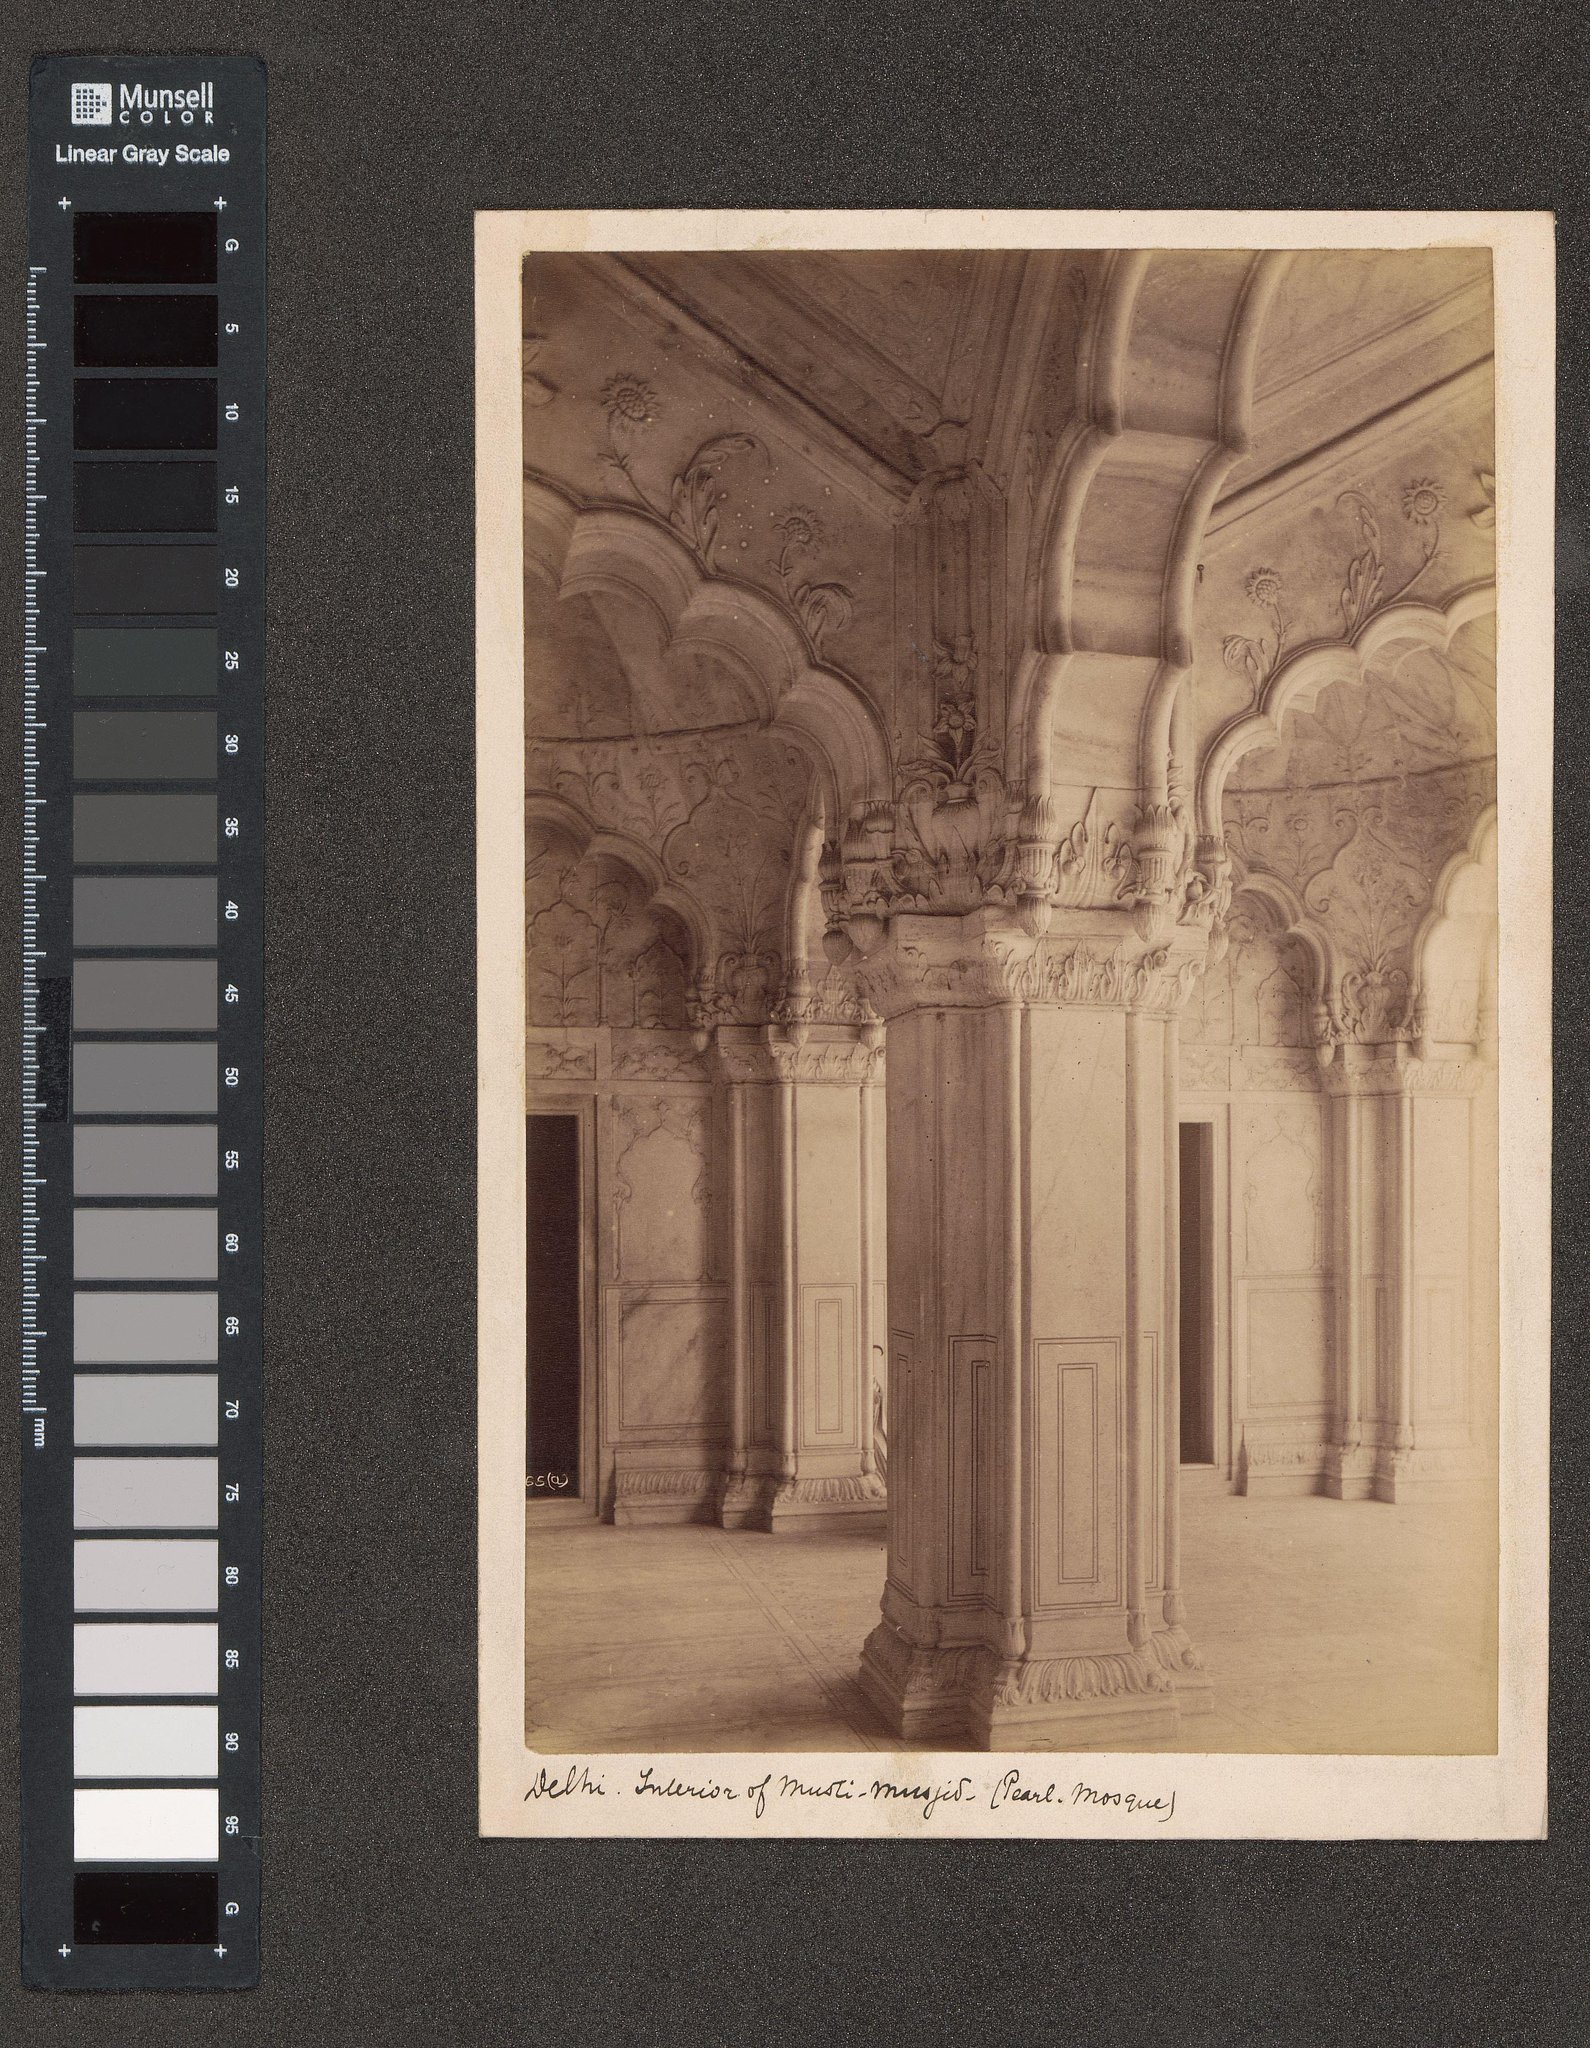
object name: photograph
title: The columns in the Moti Masjid of the Red Fort in Delhi, India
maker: lala deen dayal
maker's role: fotograaf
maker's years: 1844-1910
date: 1868-1900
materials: cardboard, paper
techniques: albumen print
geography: delhi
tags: temple, shrine ~ islam, mohammedanism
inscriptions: number: ‘65 (a)’, number: ‘29’, inscription: ‘Lala Deen Dayal’, title: ‘Delhi. Interior of Musti-Musjid - (Pearl Mosque)’